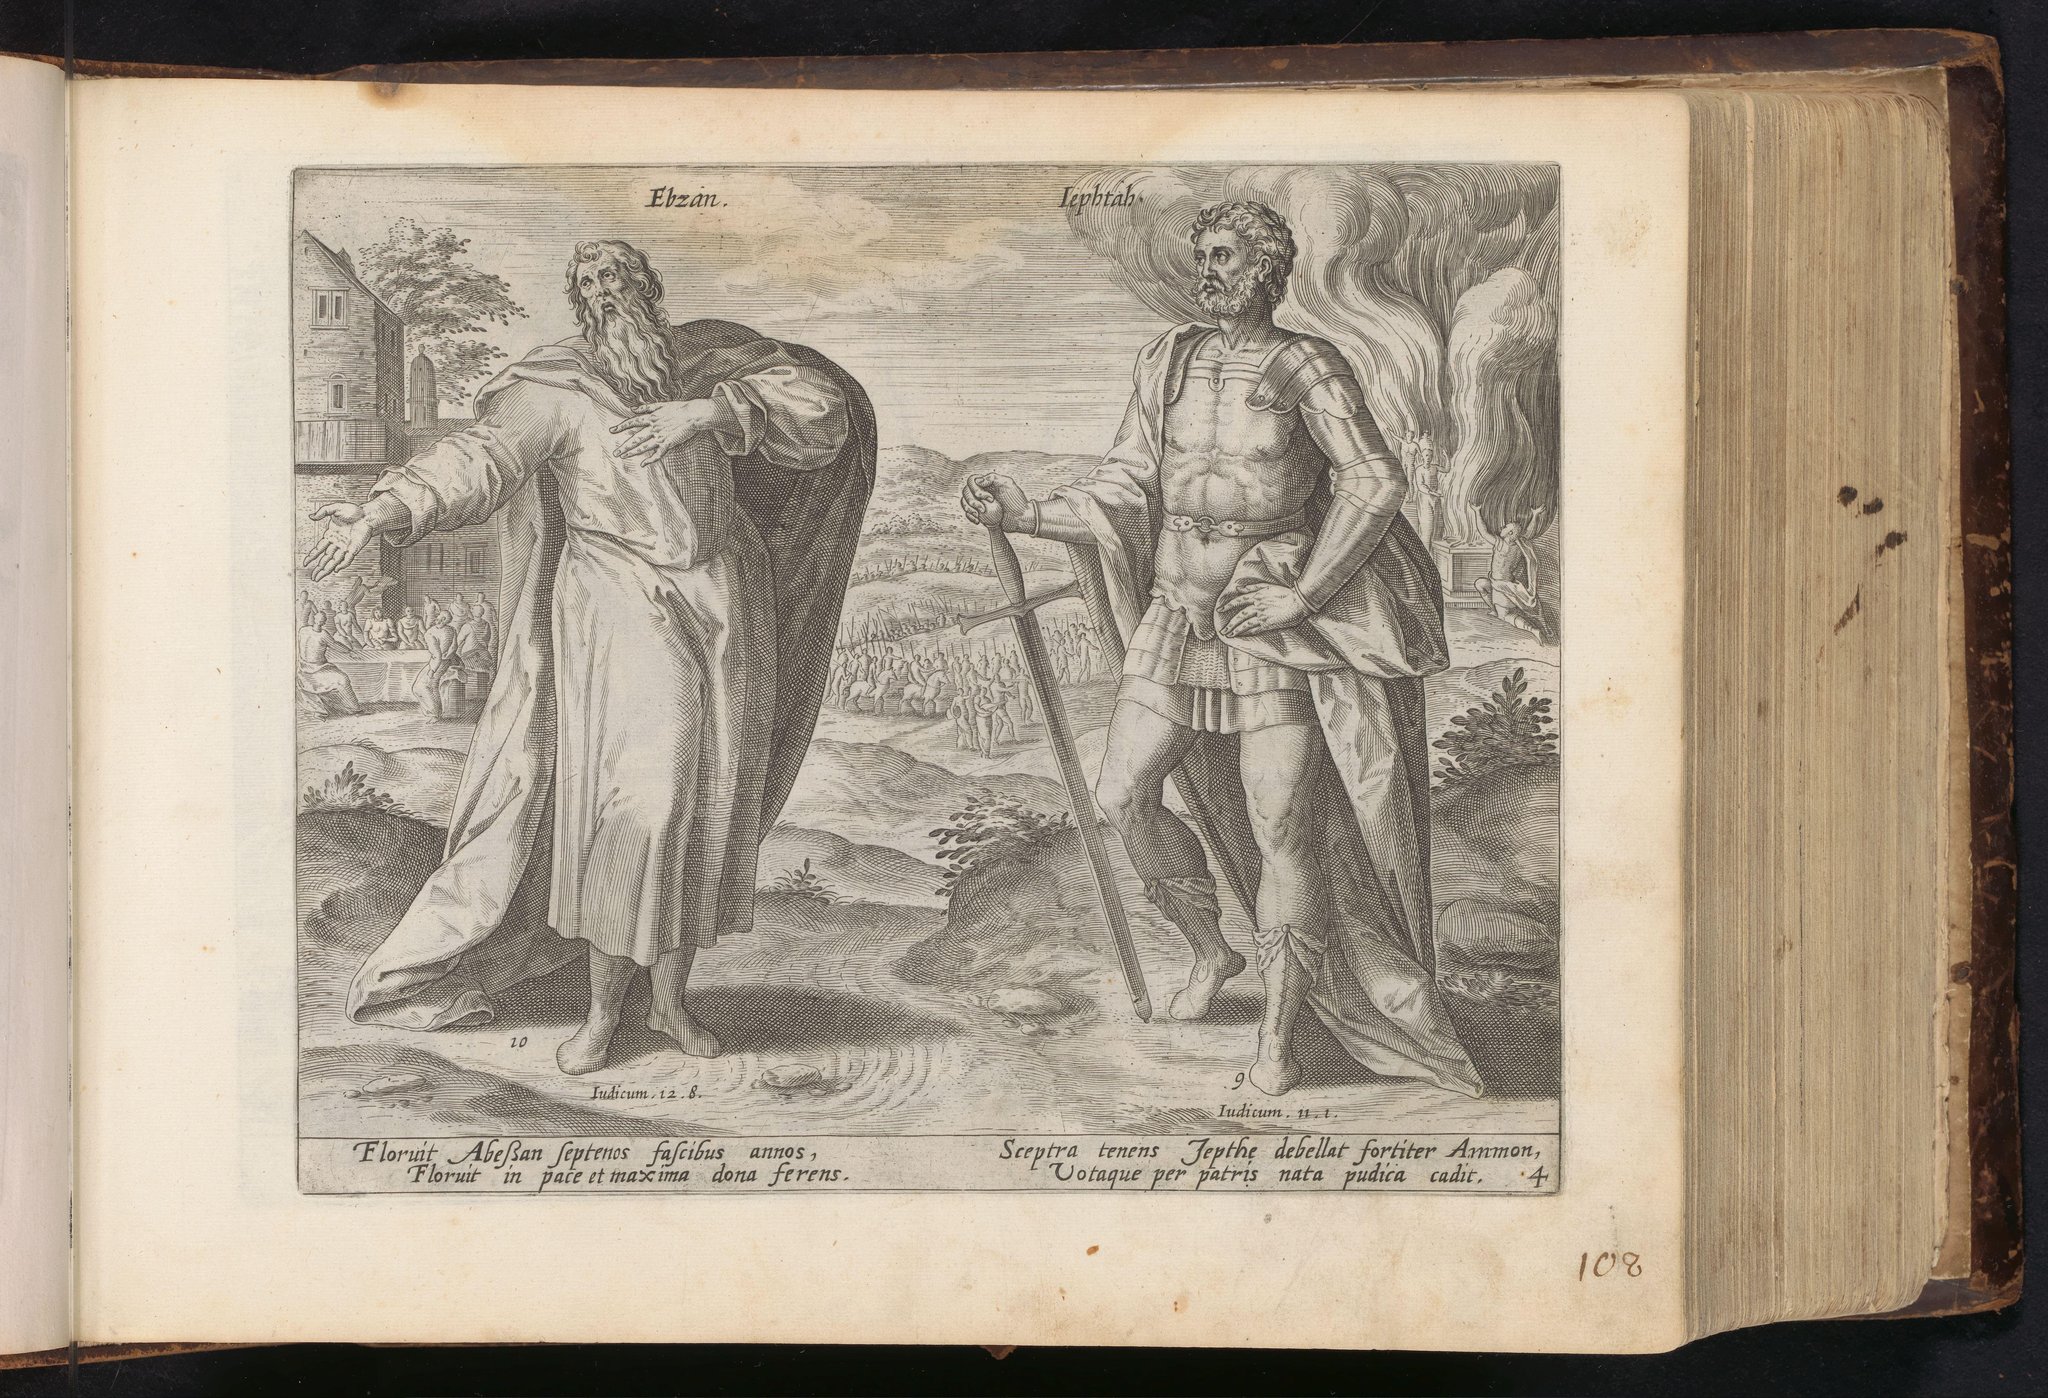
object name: album leaf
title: De twaalf rechters van Israël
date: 1579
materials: paper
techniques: engraving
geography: alkmaar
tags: fulfilment of jephthah's vow to the lord: jephthah's daughter is sacrificed, the time of ibzan (judges 12:8-10), jephthah's daughter dances with tambourines to meet her father on his return from the battle; jephthah rends his clothes in despair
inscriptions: number: ‘108’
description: De rechters Ibsan en Jefta. Ibsan wijst op de scène op de achtergrond. Voor zijn huis zit een van zijn zonen of dochters aan het bruiloftsmaal. Ibsan huwelijkte zijn dertig zonen en dertig dochters uit. Jefta is gekleed in harnas en leunt op zijn zwaard. Op de achtergrond is te zien hoe zijn dochter voorop loopt in een stoet. Jefta had God beloofd om het eerste wat hij bij zijn thuiskomst zou zien te offeren. Rechts offert Jefta zijn dochter. Onder de voorstelling toelichtende teksten in het Latijn en verwijzingen naar de Bijbelteksten in Ri. 12:8 en Ri. 11:1. Deze prent maakt deel uit van een album.